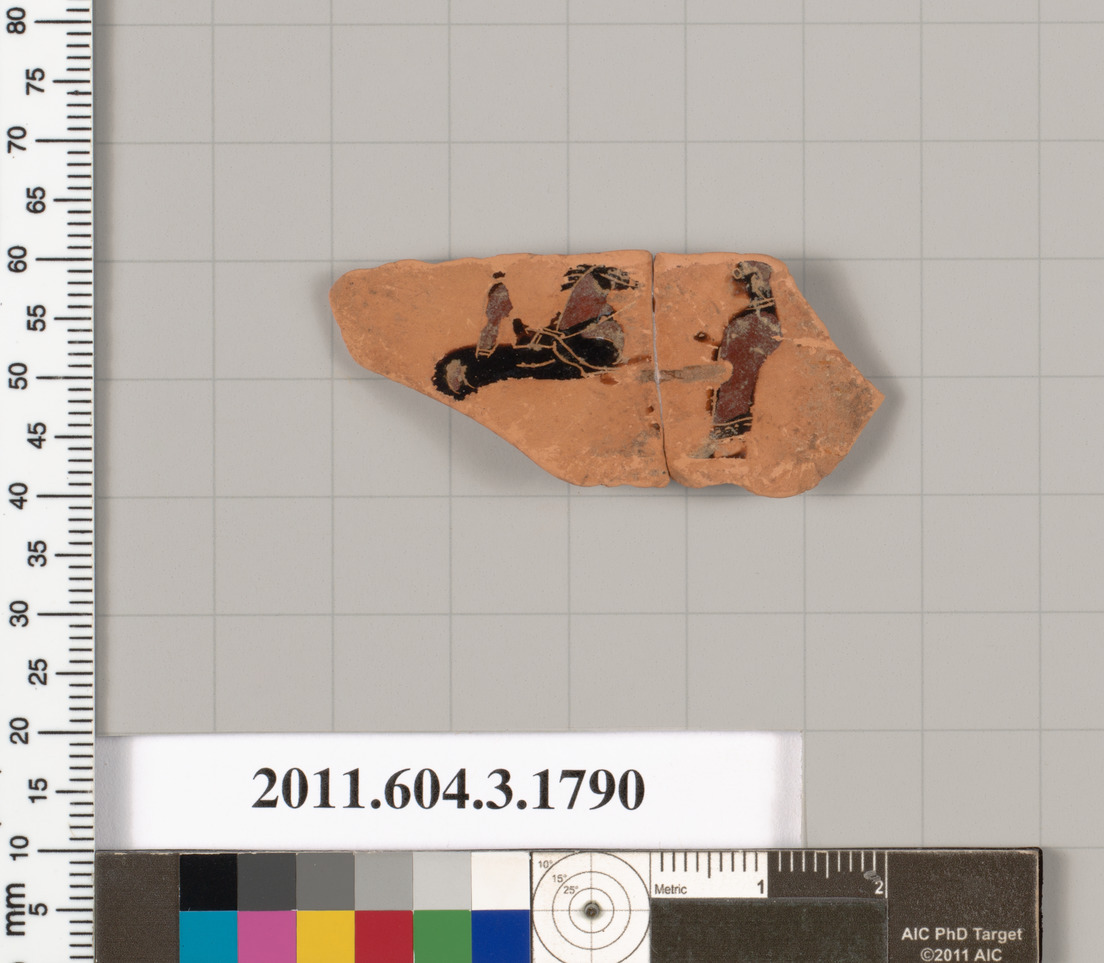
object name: kylix fragment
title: Terracotta rim fragment of a kylix: Lip cup (drinking cup)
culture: greek, attic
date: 560-550 BCE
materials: terracotta